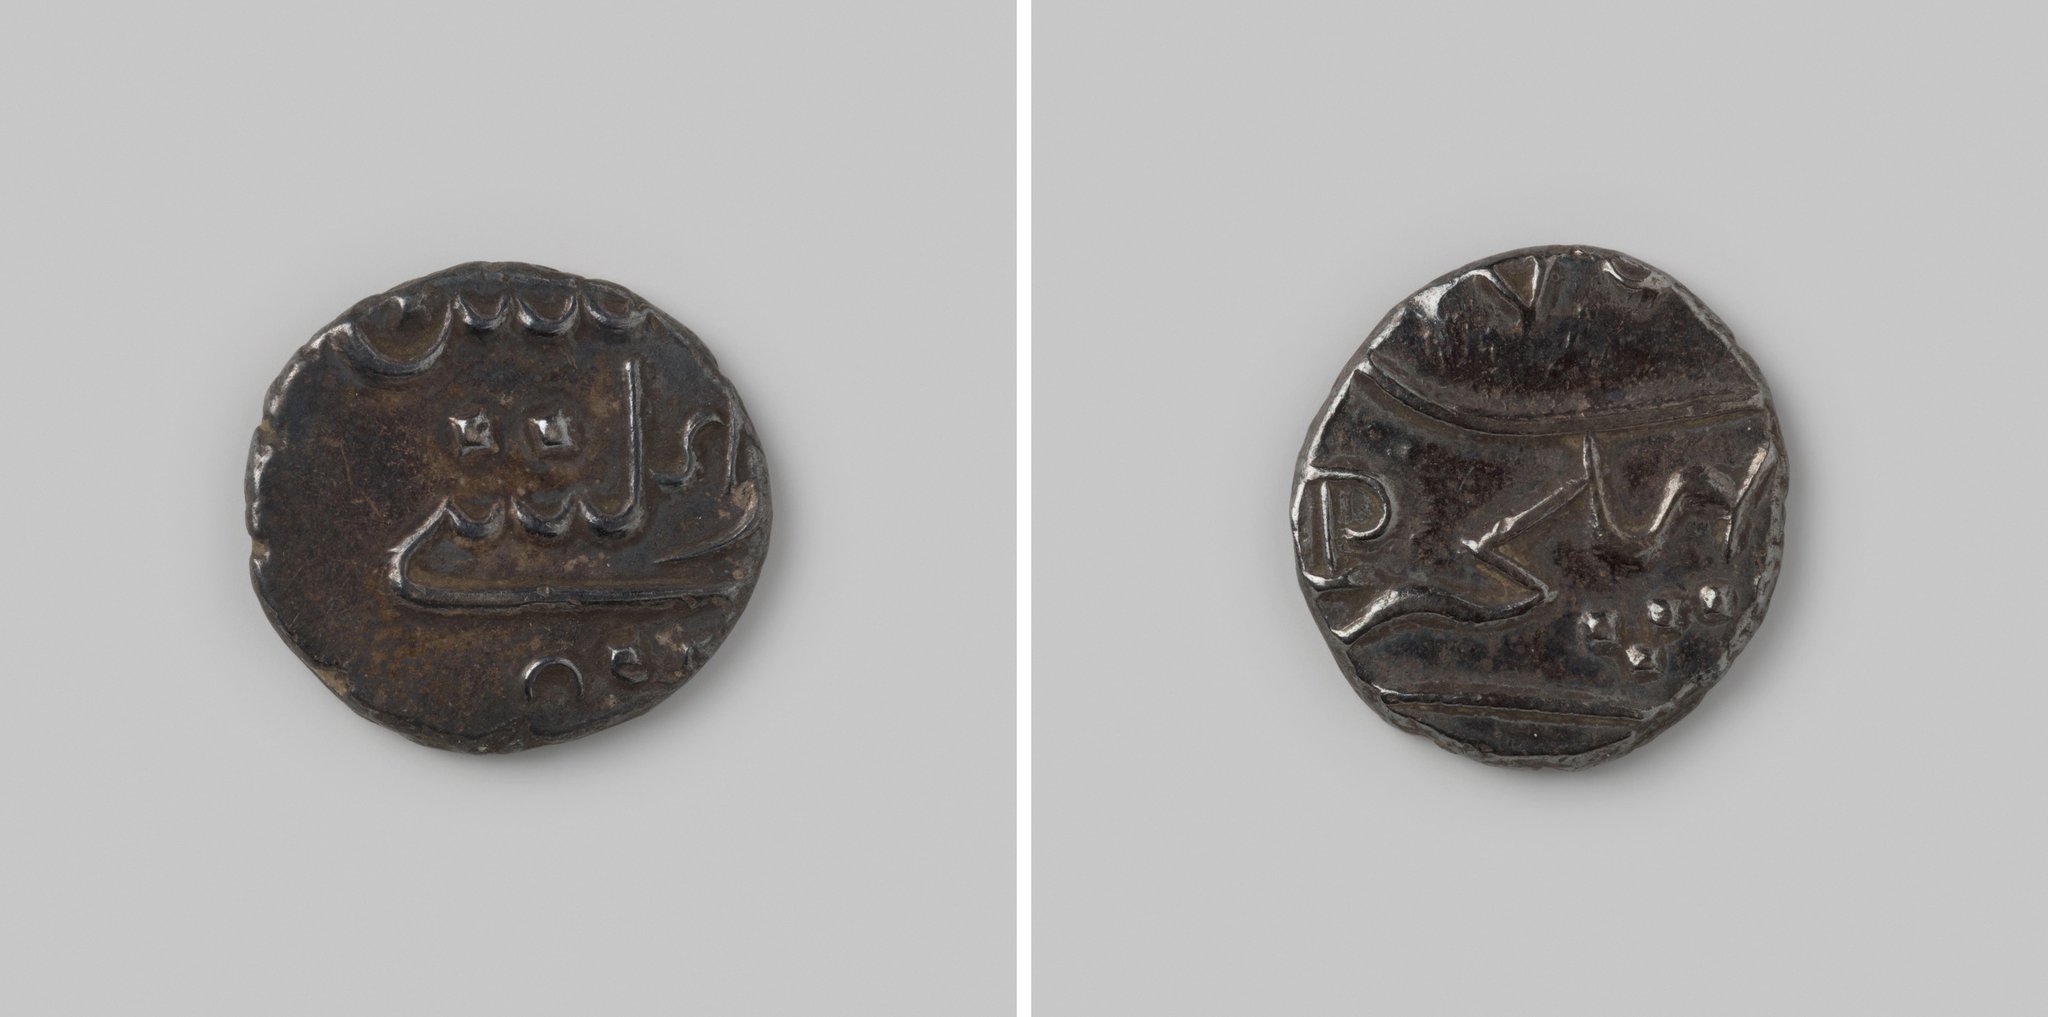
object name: coin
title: Fanon [=1/5 roepie] uit Mahé in India van de Franse Compagnie perpétuelle des Indes,1750 [?]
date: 1750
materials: silver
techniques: striking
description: Zilveren munt. Voorzijde: in Arabische lettertekens in drie regels opschrift. Keerzijde: in Arabische lettertekens in drie regels opschrift, waaronder jaartal [?]. links op middelste regel Latijnse letter P [=Pondicherry].